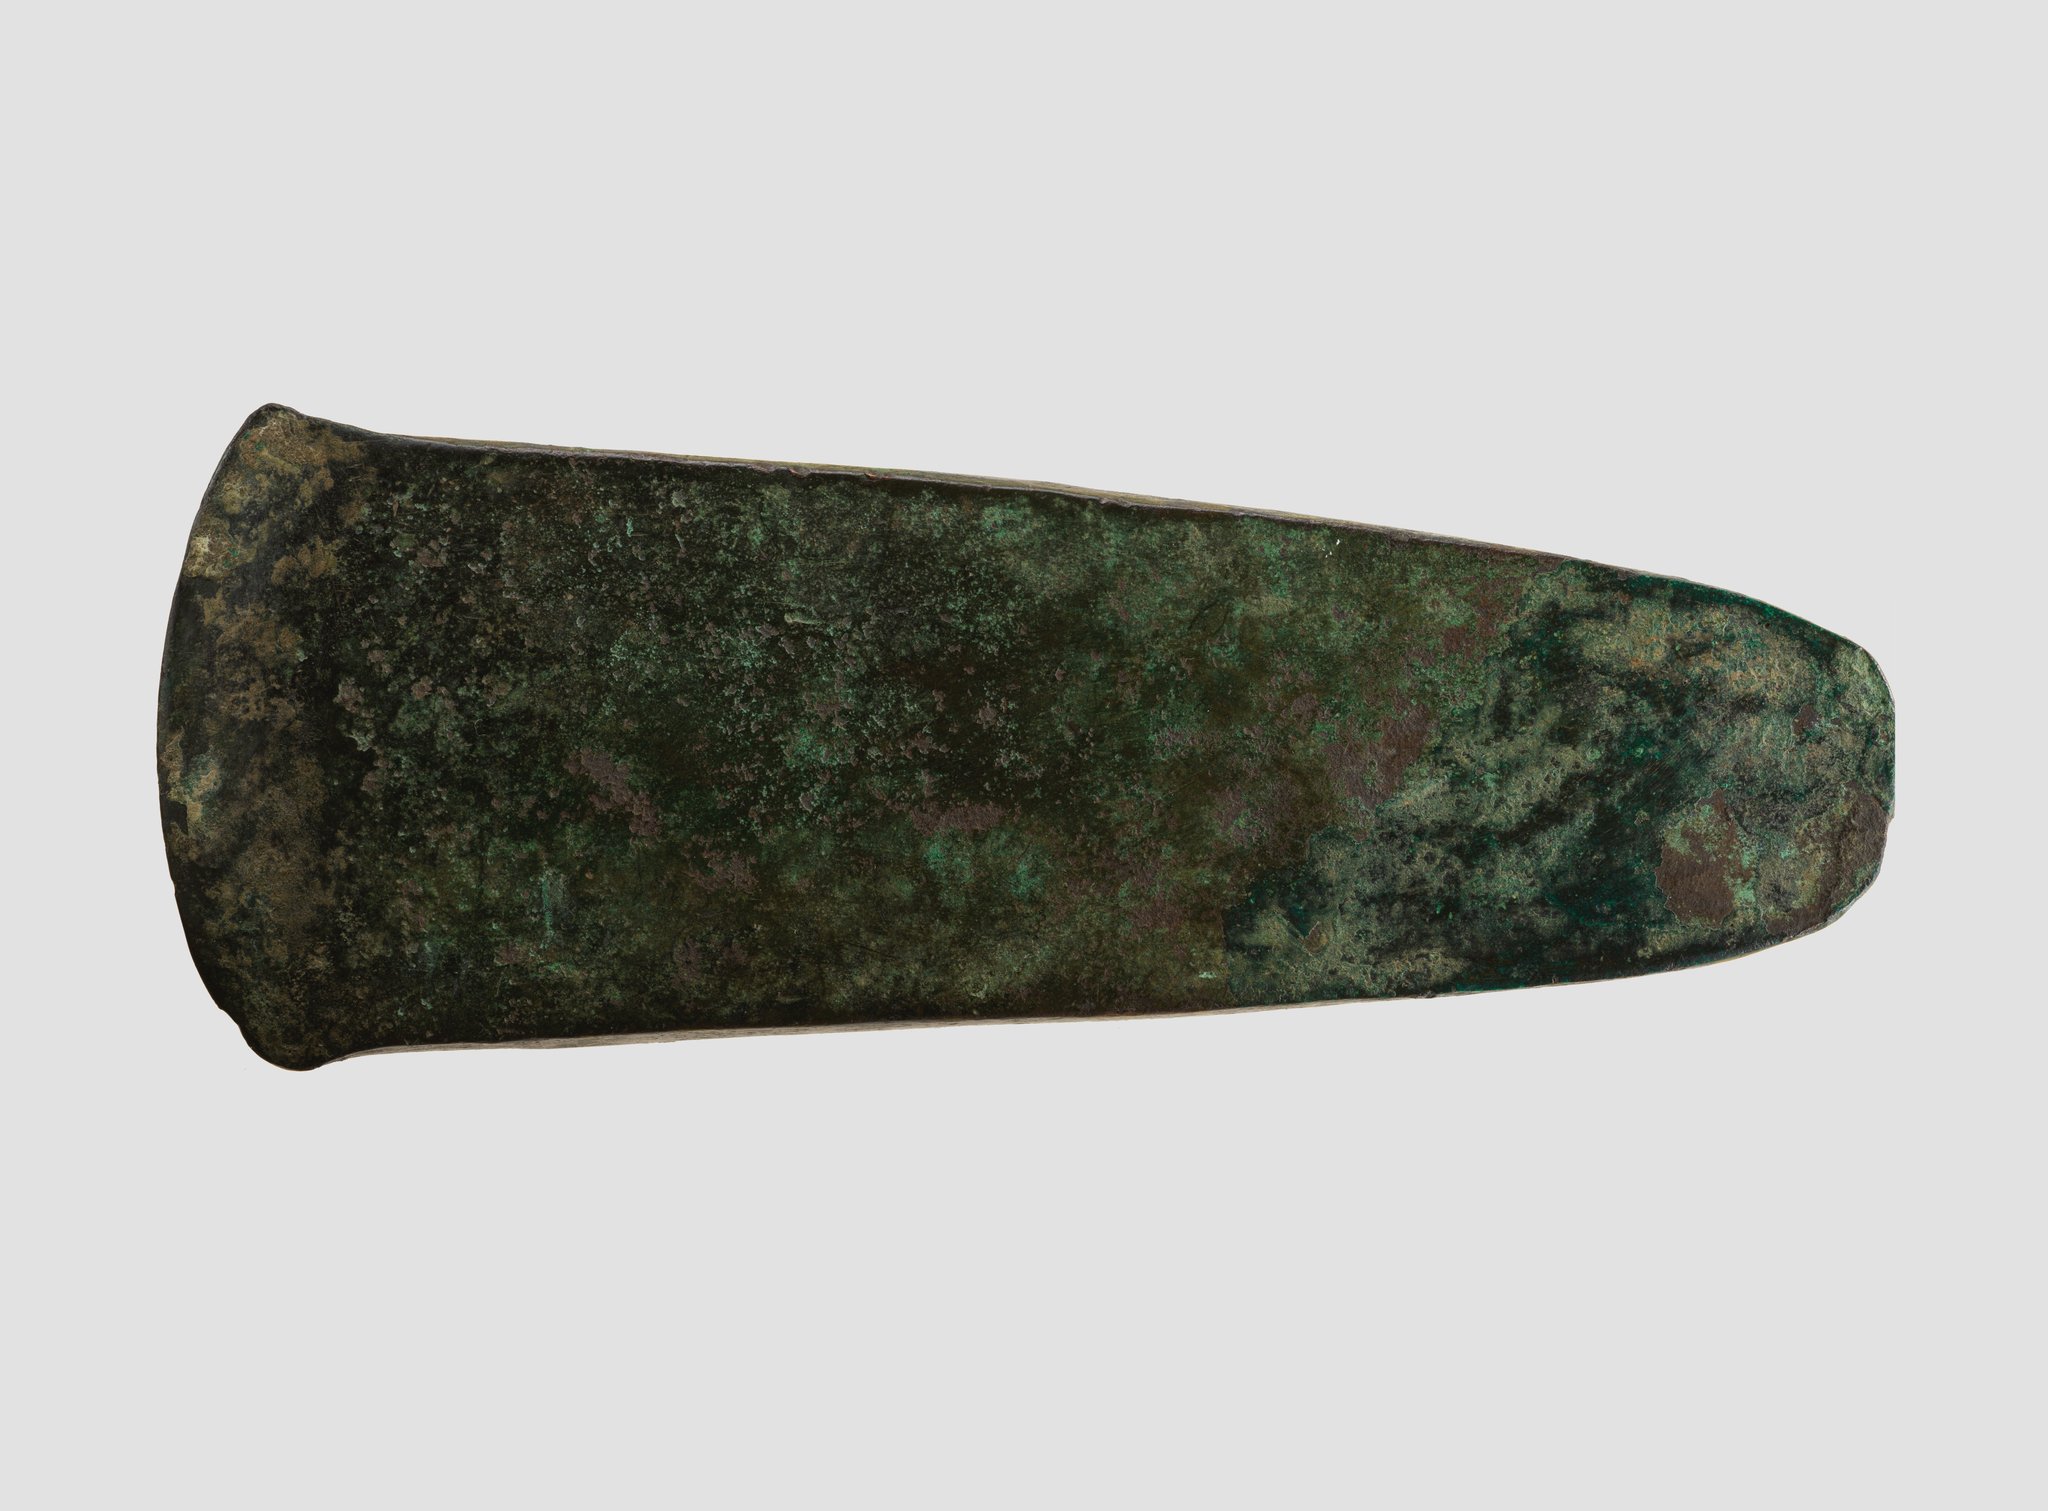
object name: adze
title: Adze head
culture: hattian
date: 2300-2000 BCE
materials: bronze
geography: central anatolia